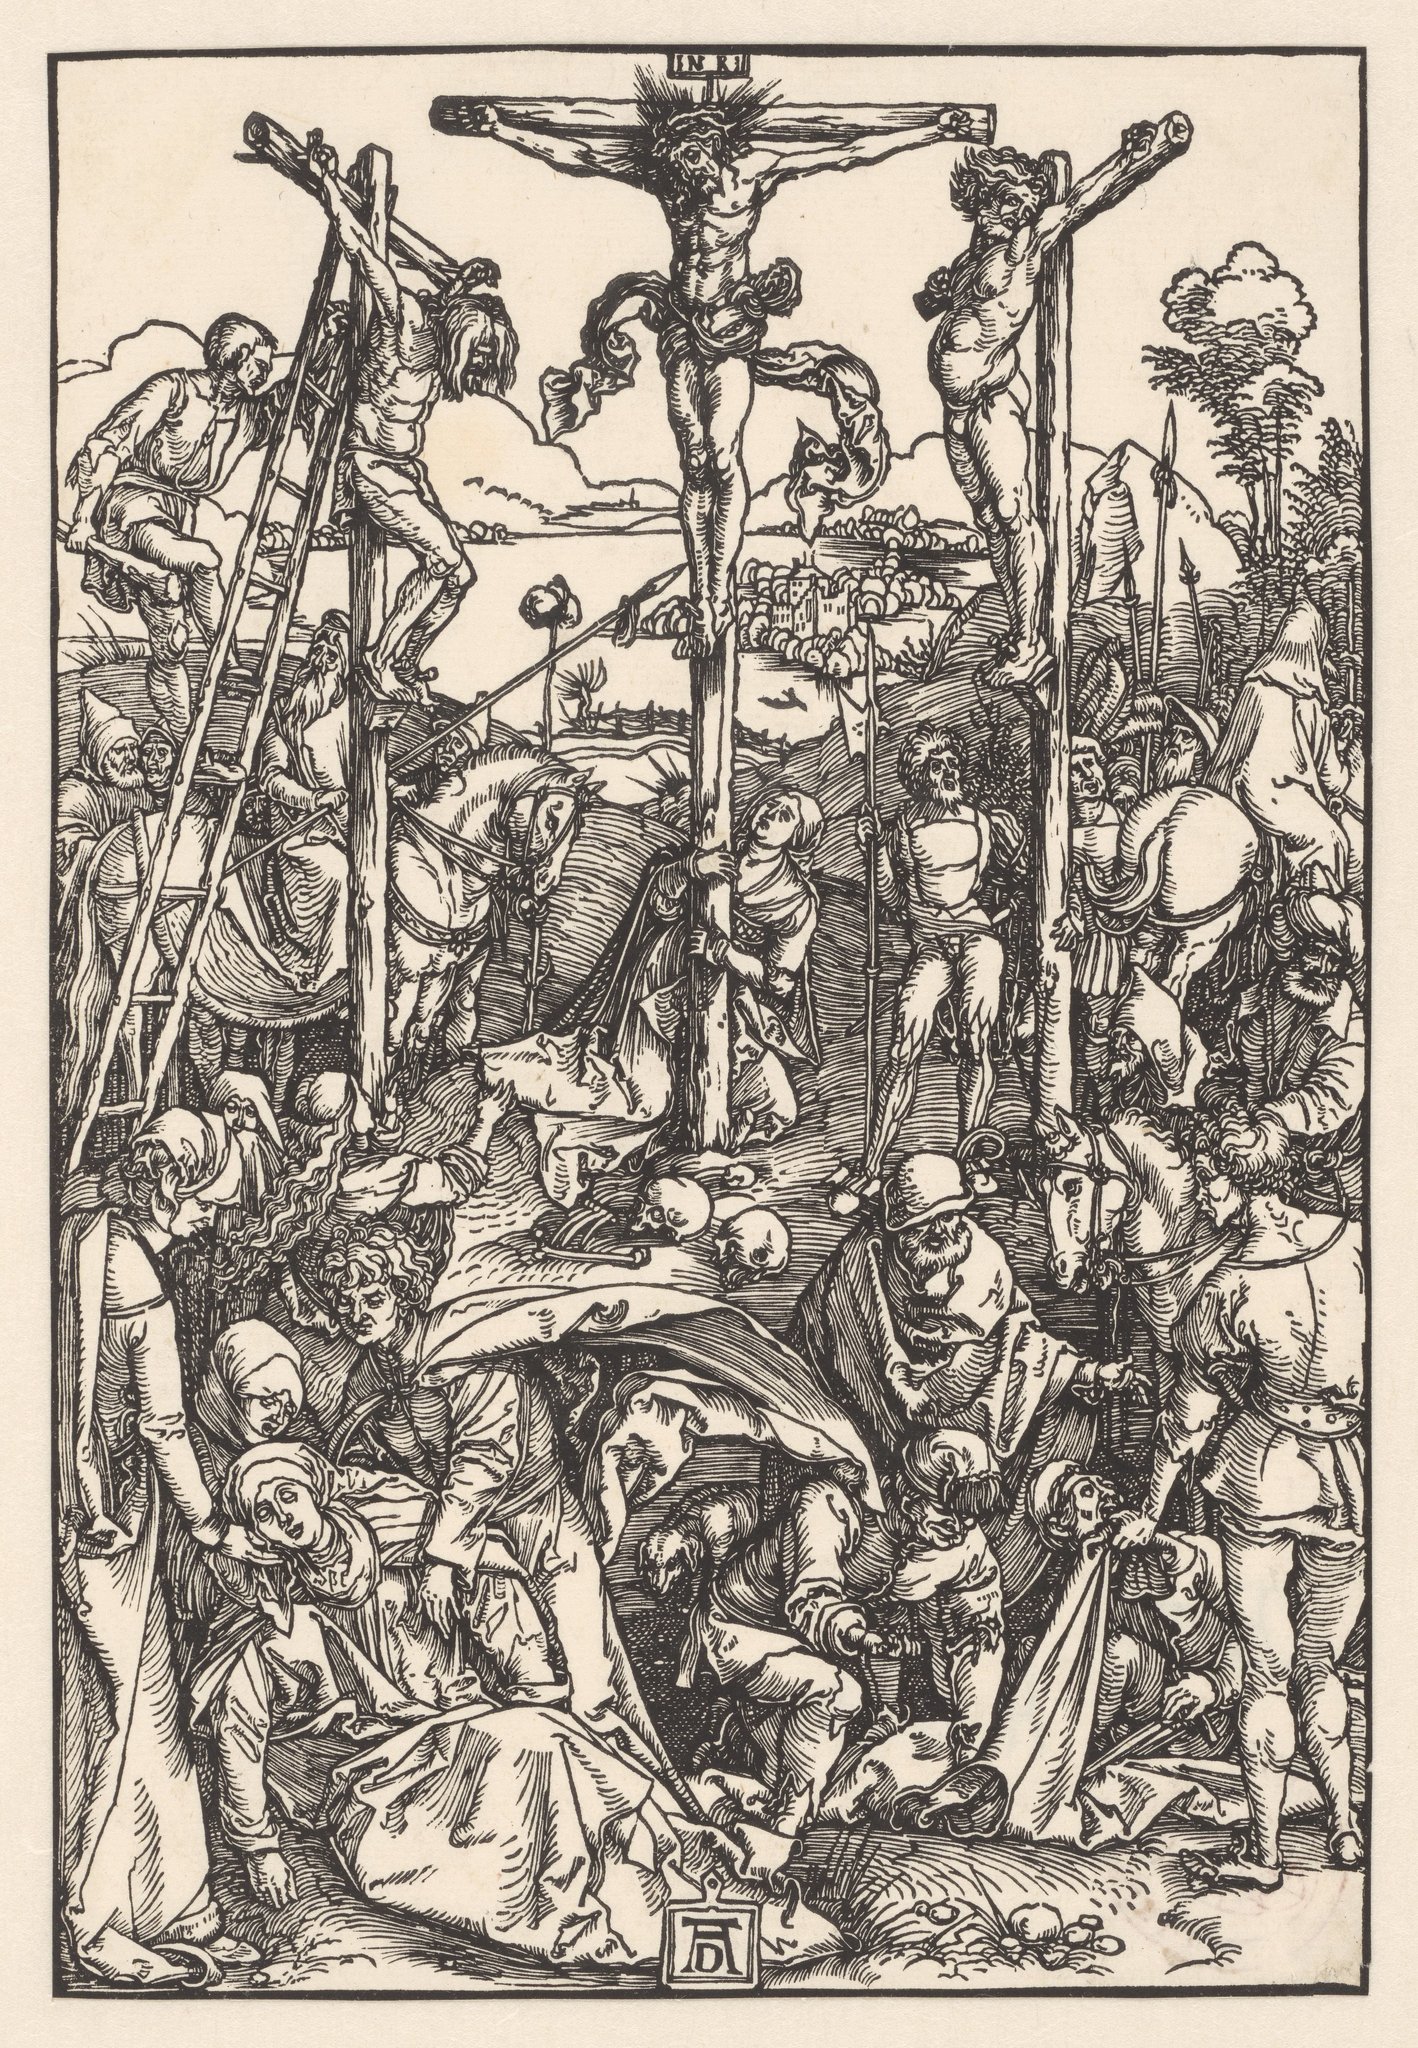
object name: print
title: Kruisiging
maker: albrecht dürer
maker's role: draughtsman, painter, print maker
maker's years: 1471-1528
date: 1503-1504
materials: paper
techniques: woodcut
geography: nuremberg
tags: comprehensive representations of the events on golgotha during christ's hanging on the cross, no particular event emphasized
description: Christus aan het kruis tussen de twee gekruisigde misdadigers. Maria Magdalena omarmt de voet van het kruis van Christus. Links op de voorgrond valt de moeder van Christus valt in zwijm. Rechts op de voorgrond dobbelt een aantal mannen om Christus' kleren.